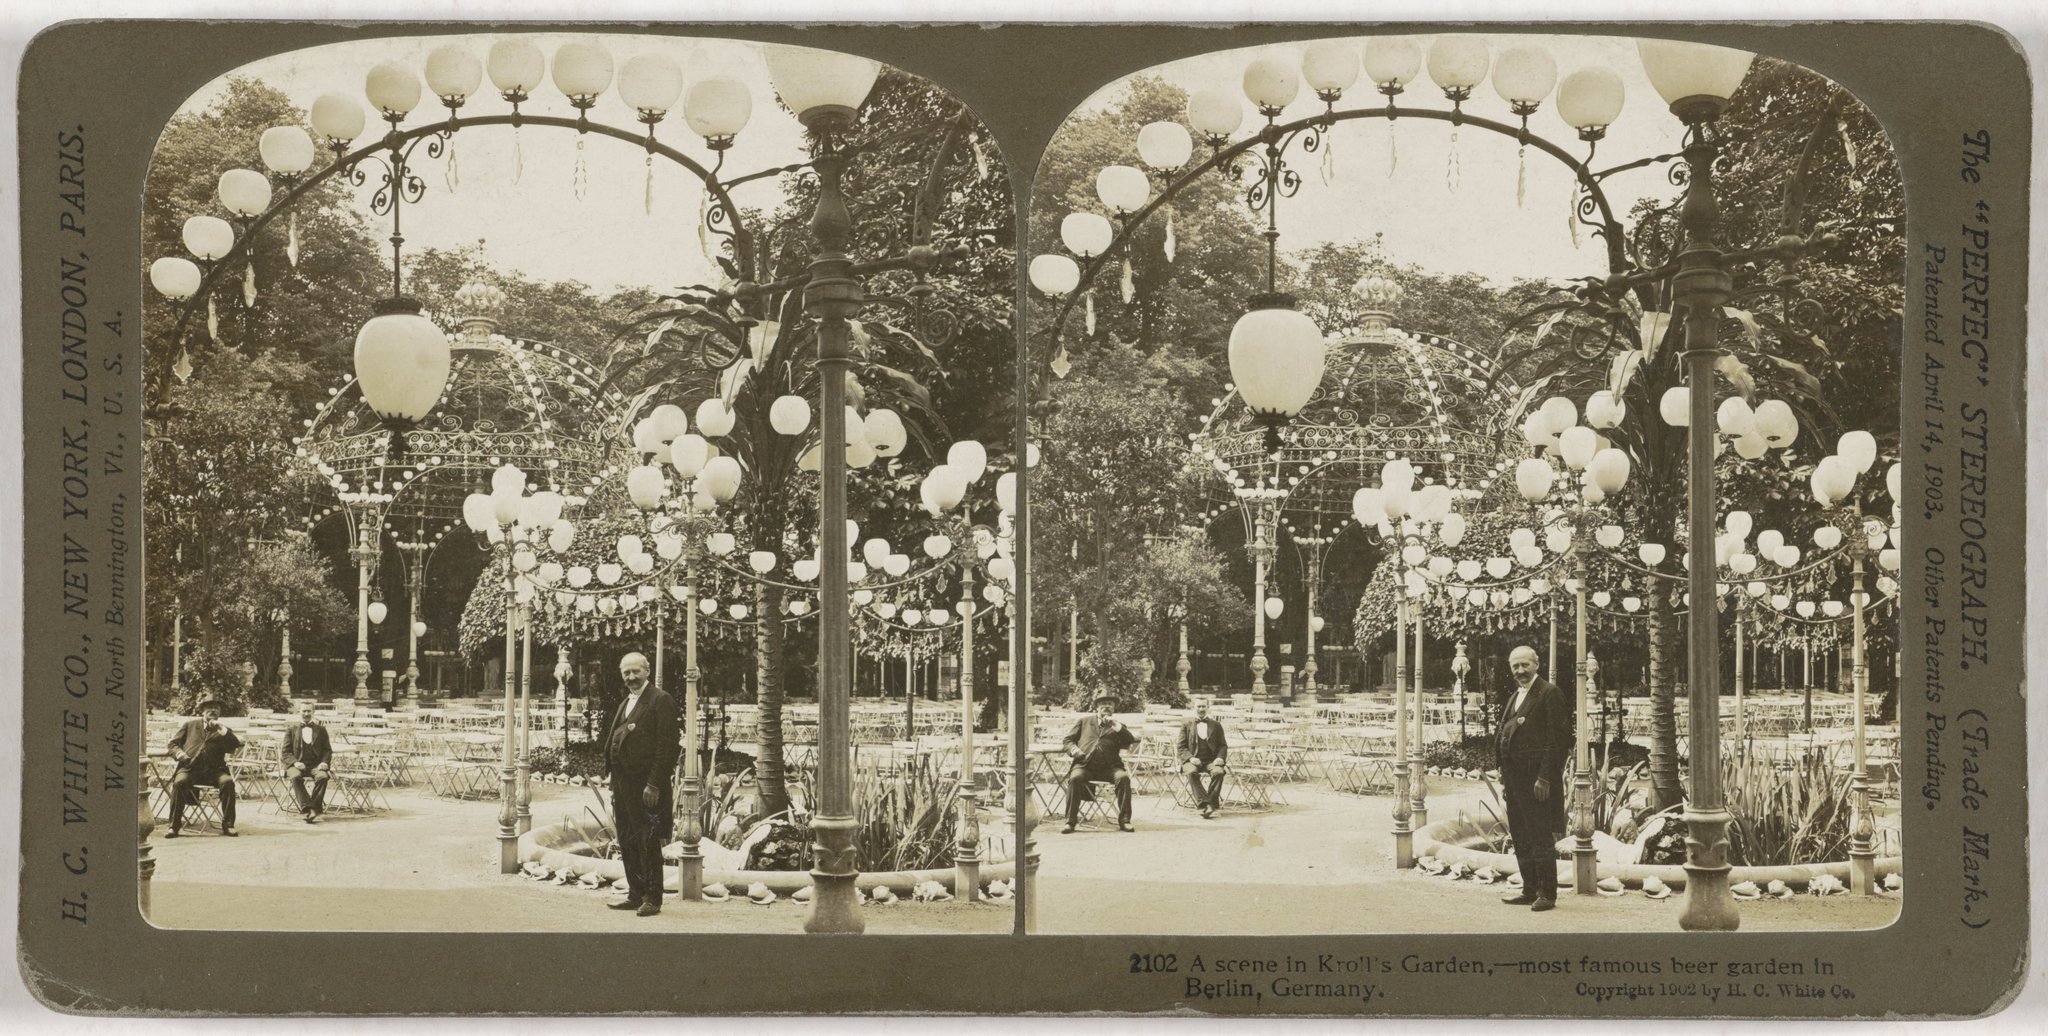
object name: stereograph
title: A scene in Kroll's Garden,-most famous beer garden in Berlin, Germany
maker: Anonymous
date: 1902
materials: cardboard, photographic support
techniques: gelatin silver print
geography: berlin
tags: pavement, terrace in front of inn or restaurant, berlin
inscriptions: copyright notice: ‘Copyright 1902 by H. C. White Co.’, inscription: ‘The " PERFEC" STEREOGRAPH. (Trade Mark.)/ Patented April 14, 1903. Other Patents Pending.’, number: ‘2102’, inscription: ‘A Scene in Kroll's Garden, Berlin, Germany./ (...)’